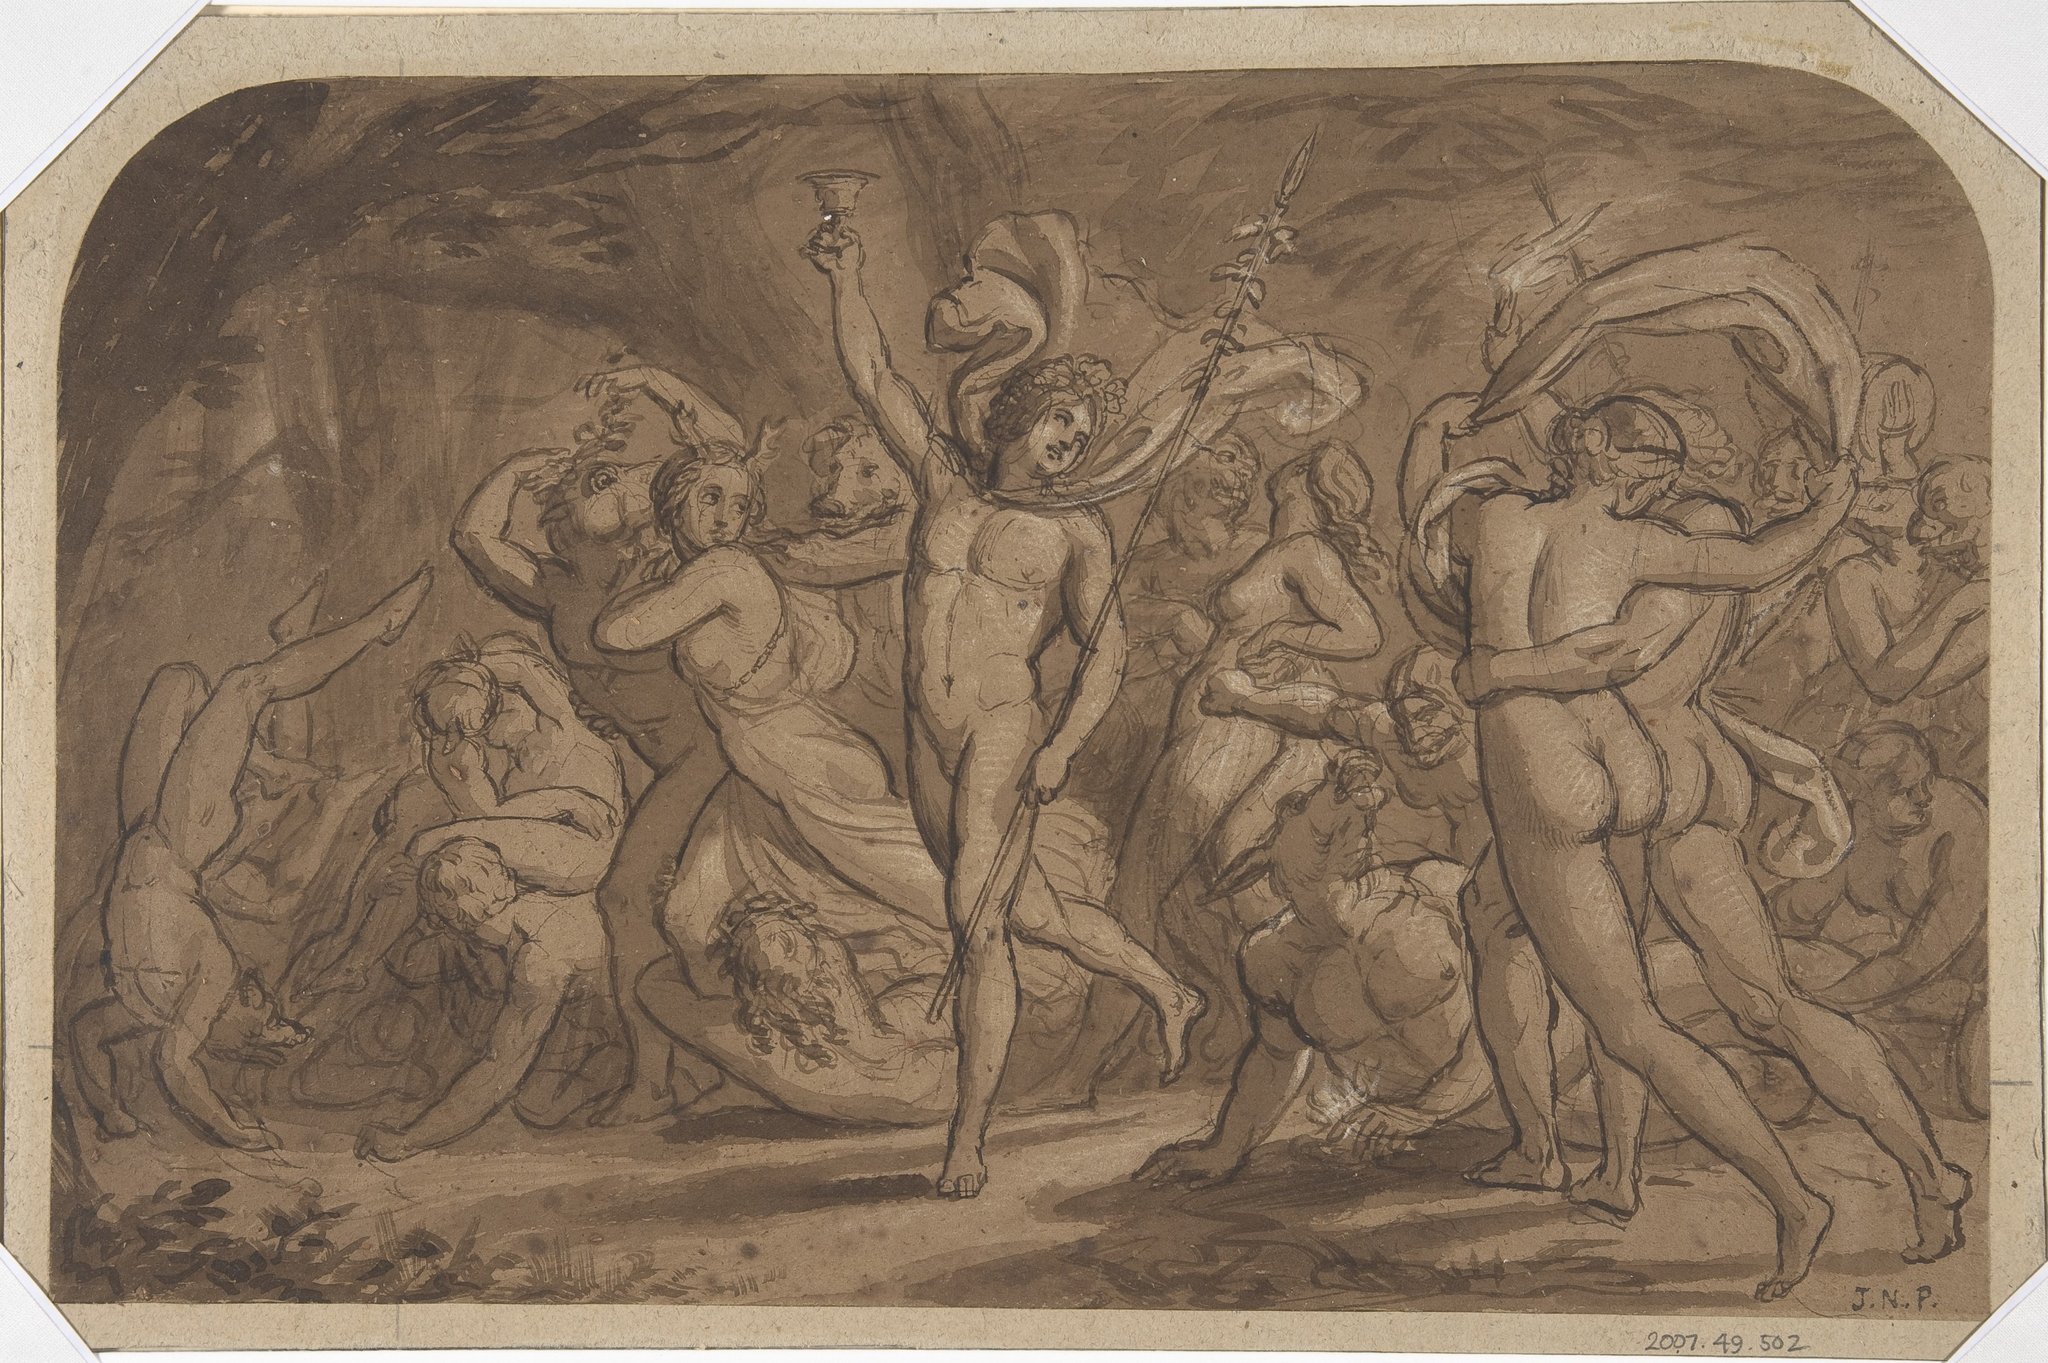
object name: drawing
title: Milton's Comus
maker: sir joseph noël paton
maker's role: artist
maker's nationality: british, scottish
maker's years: 1821-1901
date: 1842-1848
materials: gouache, ink, paper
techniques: brush, pen, wash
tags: male nudes,female nudes